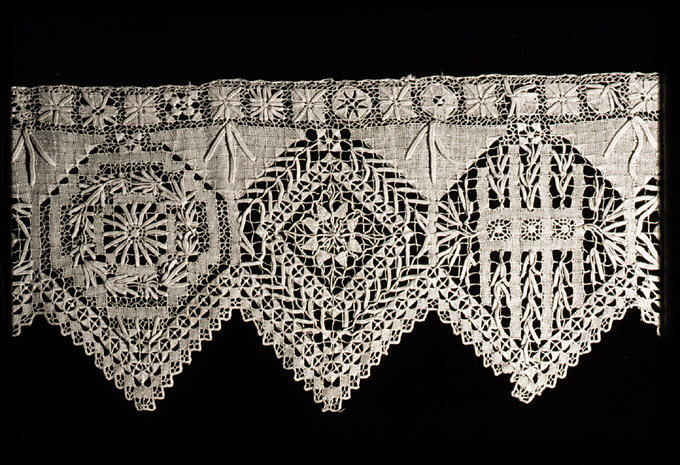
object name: border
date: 1801-1900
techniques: embroidery